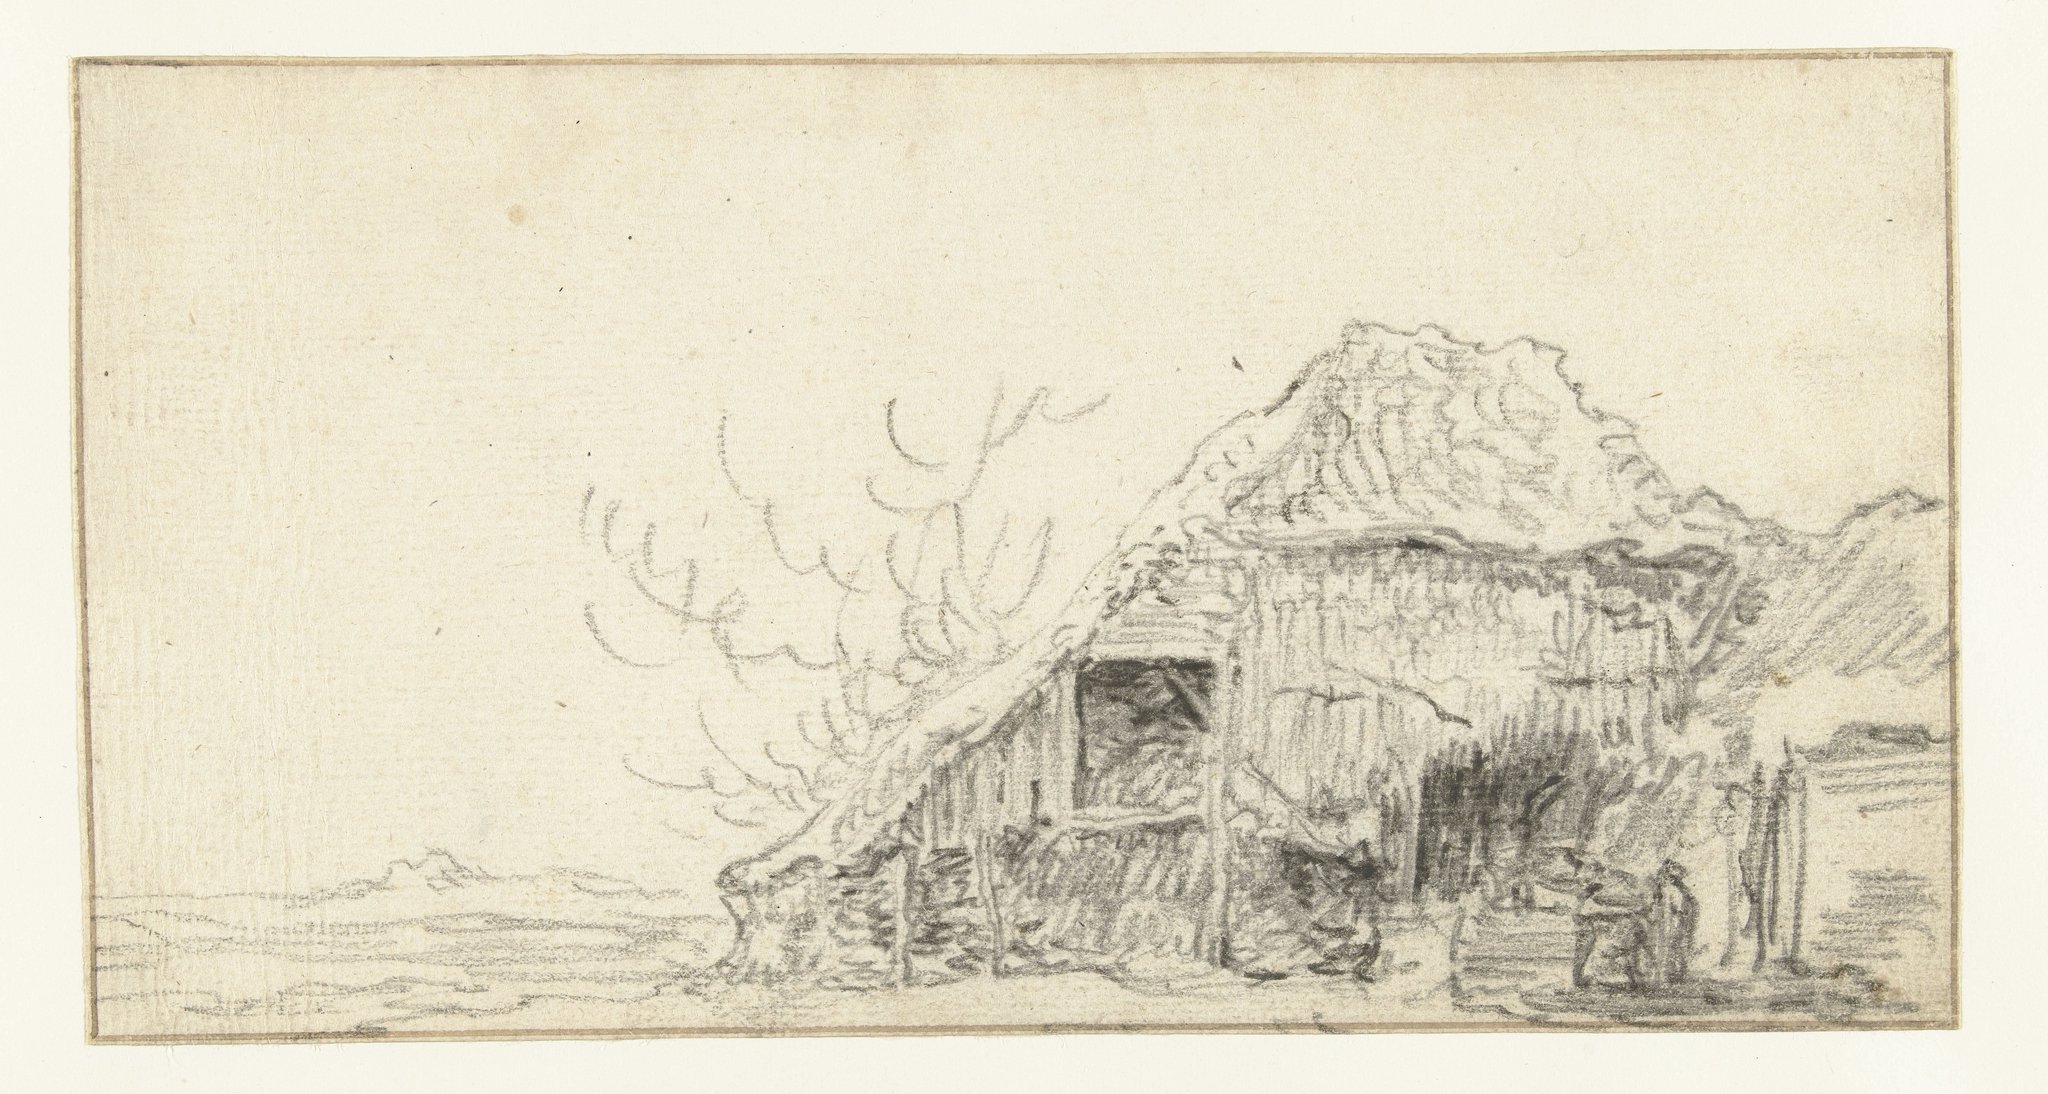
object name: drawing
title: Boerenschuur in een vlak landschap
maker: pieter de molijn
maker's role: draughtsman, painter, print maker, publisher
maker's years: 1595-1661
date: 1650-1660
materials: chalk, paper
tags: farm (building)